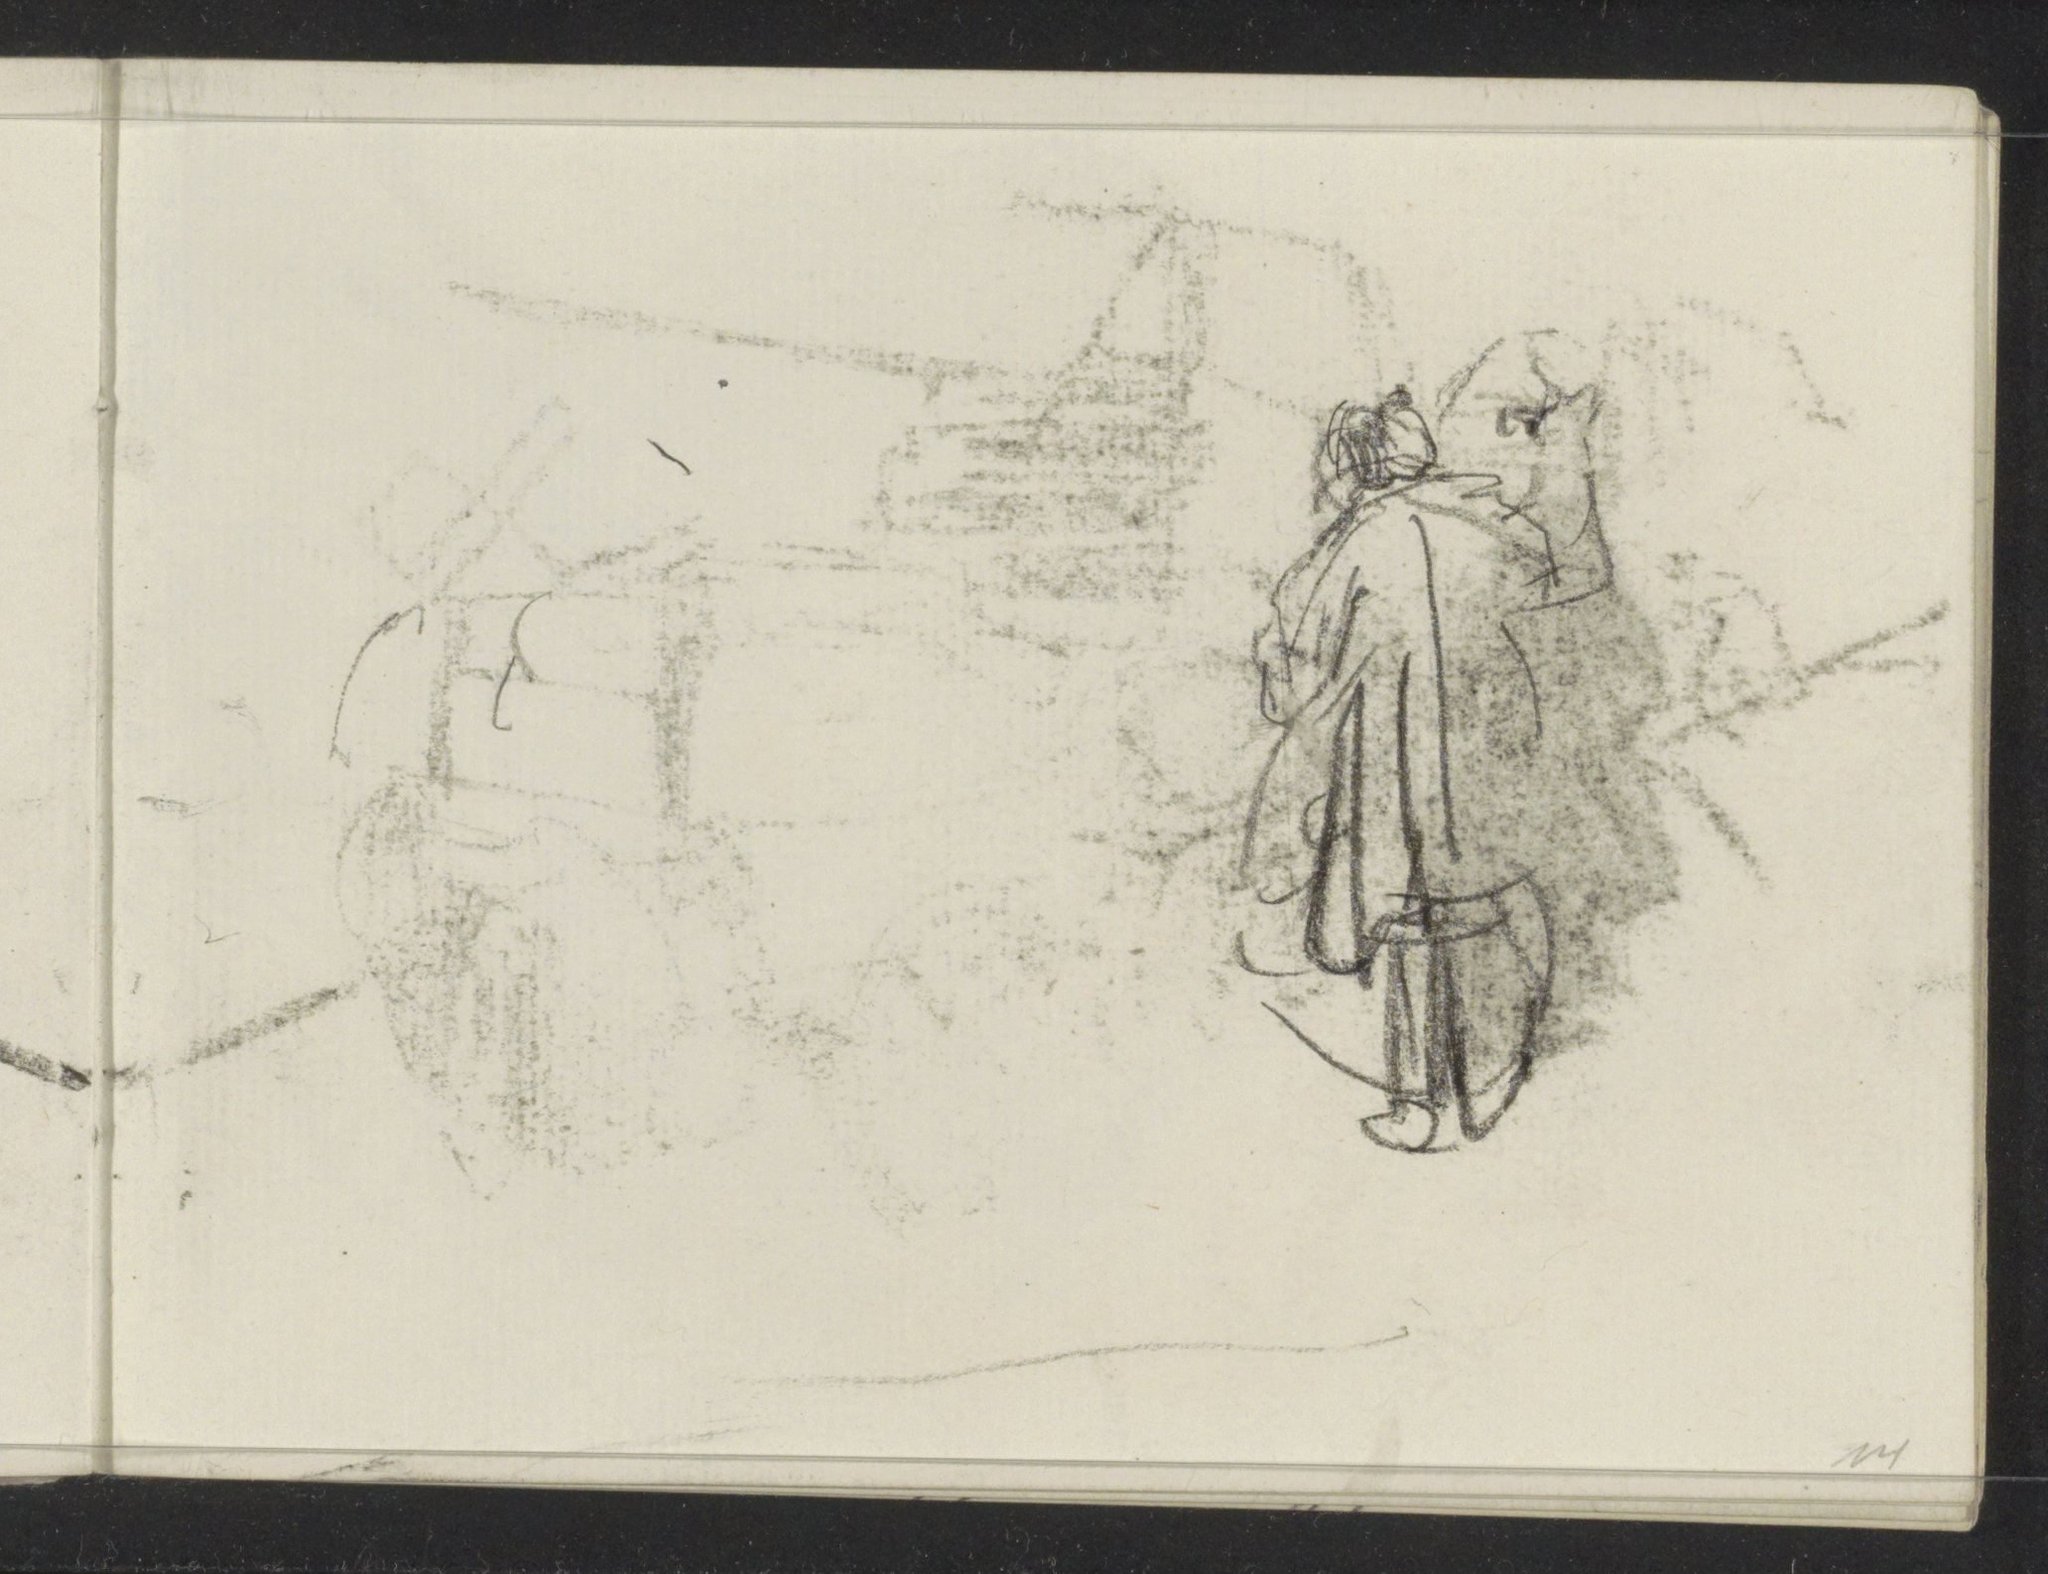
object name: sketchbook leaf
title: Staande man, op de rug gezien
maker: isaac israels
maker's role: draughtsman, painter, print maker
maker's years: 1865-1934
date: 1886-1934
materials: chalk, paper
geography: amsterdam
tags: adult man (+ standing)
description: Met geheven rechterarm. Blad 14 recto uit schetsboek LXIV met 29 bladen.